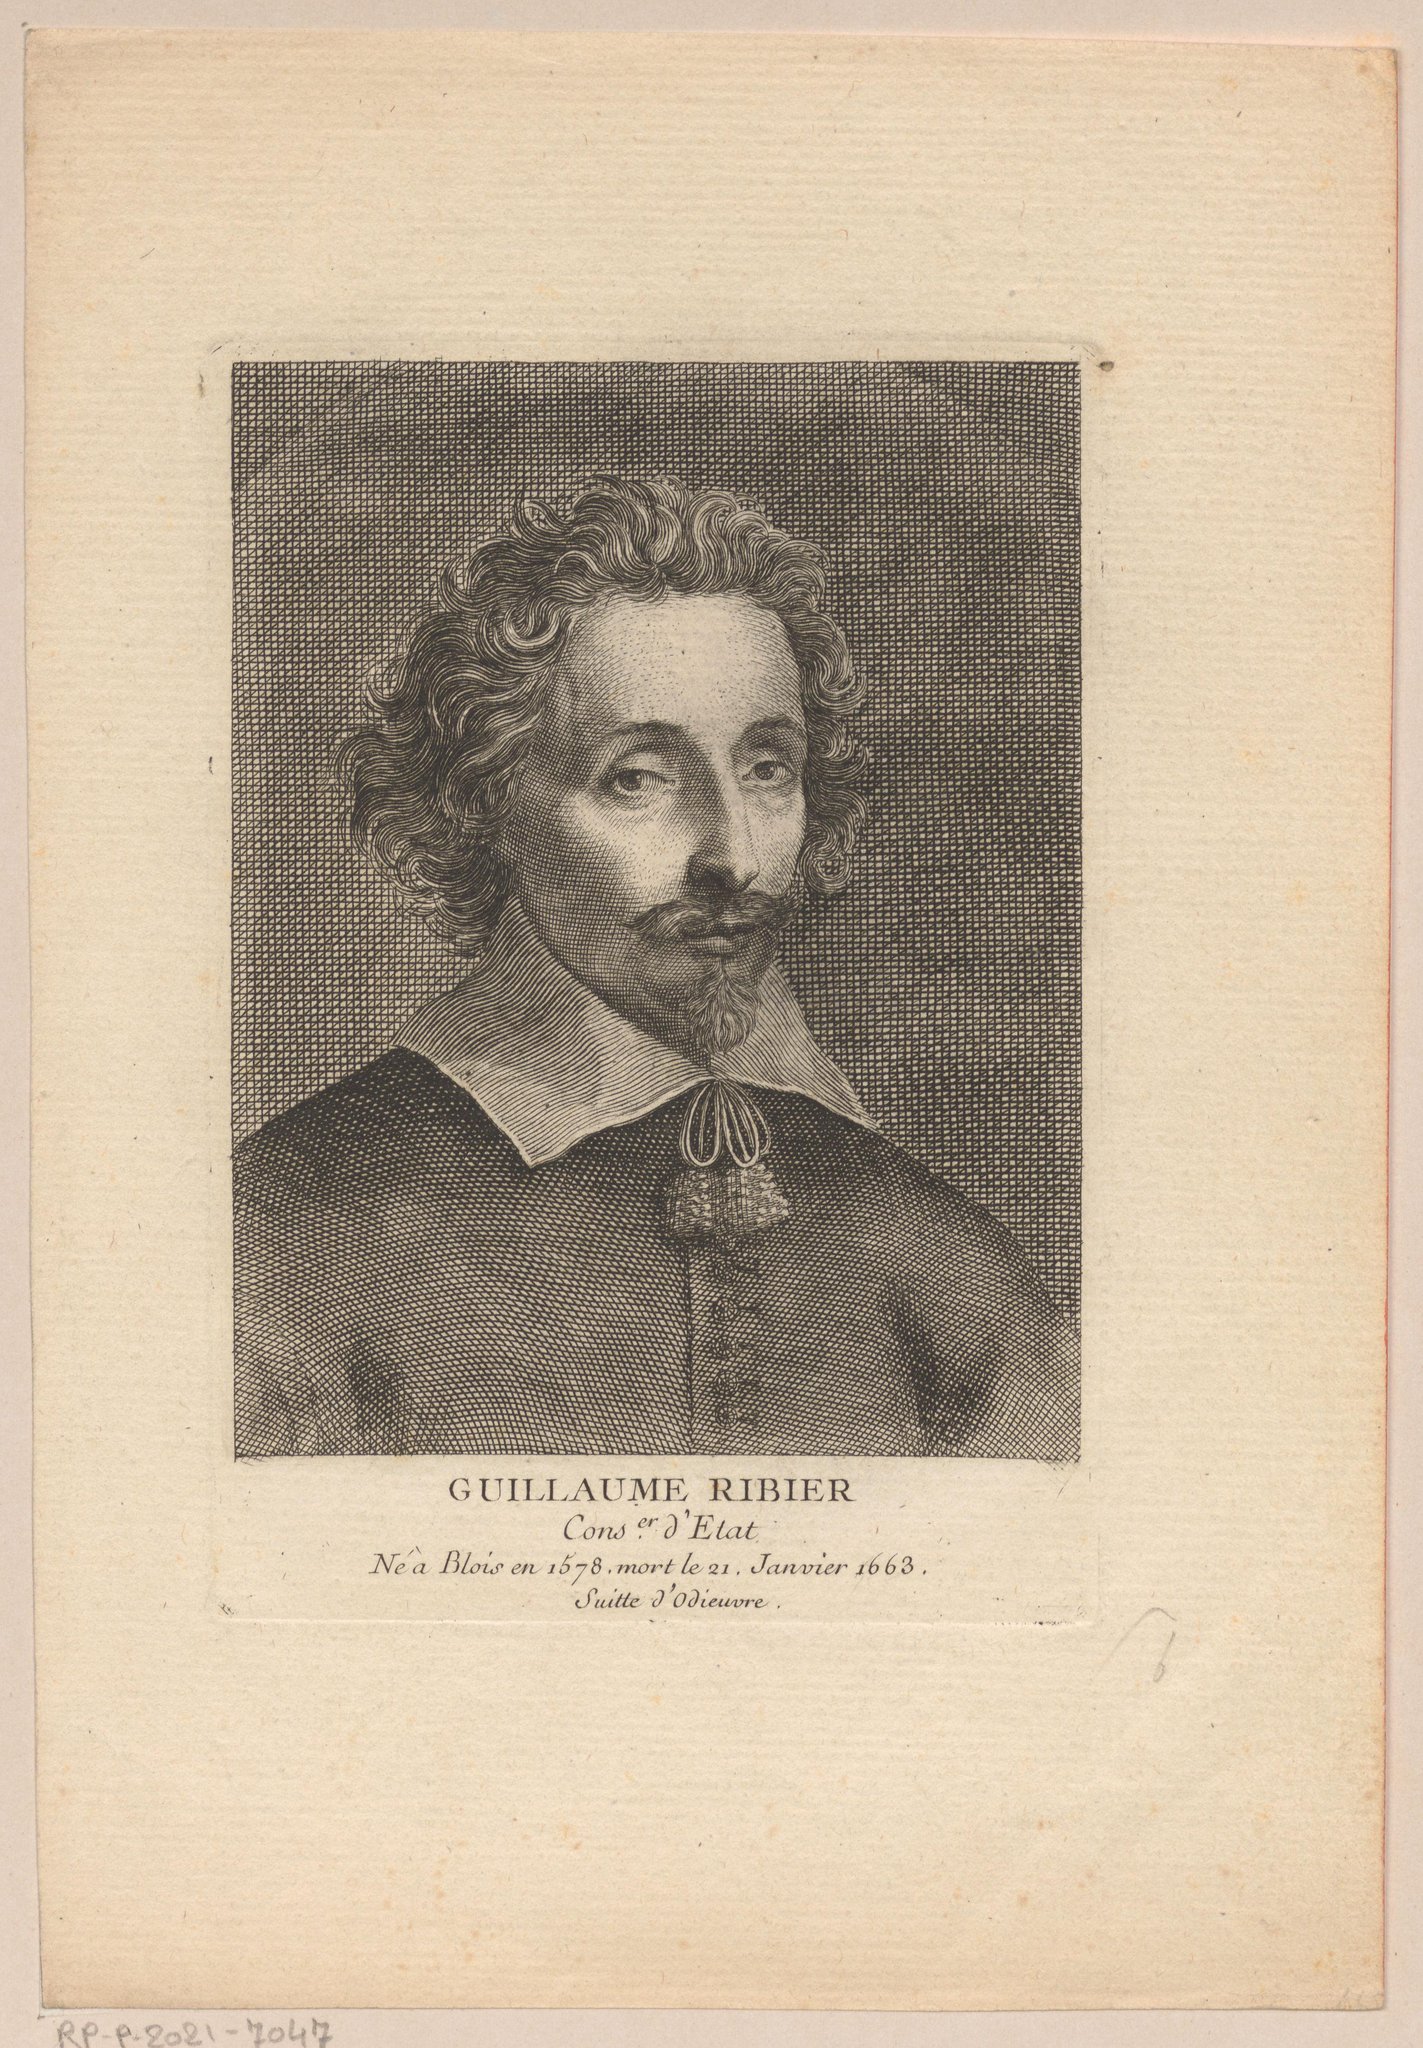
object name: print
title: Portret van Guillaume Ribier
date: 1697-1756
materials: paper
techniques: engraving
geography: paris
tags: politician, historical persons